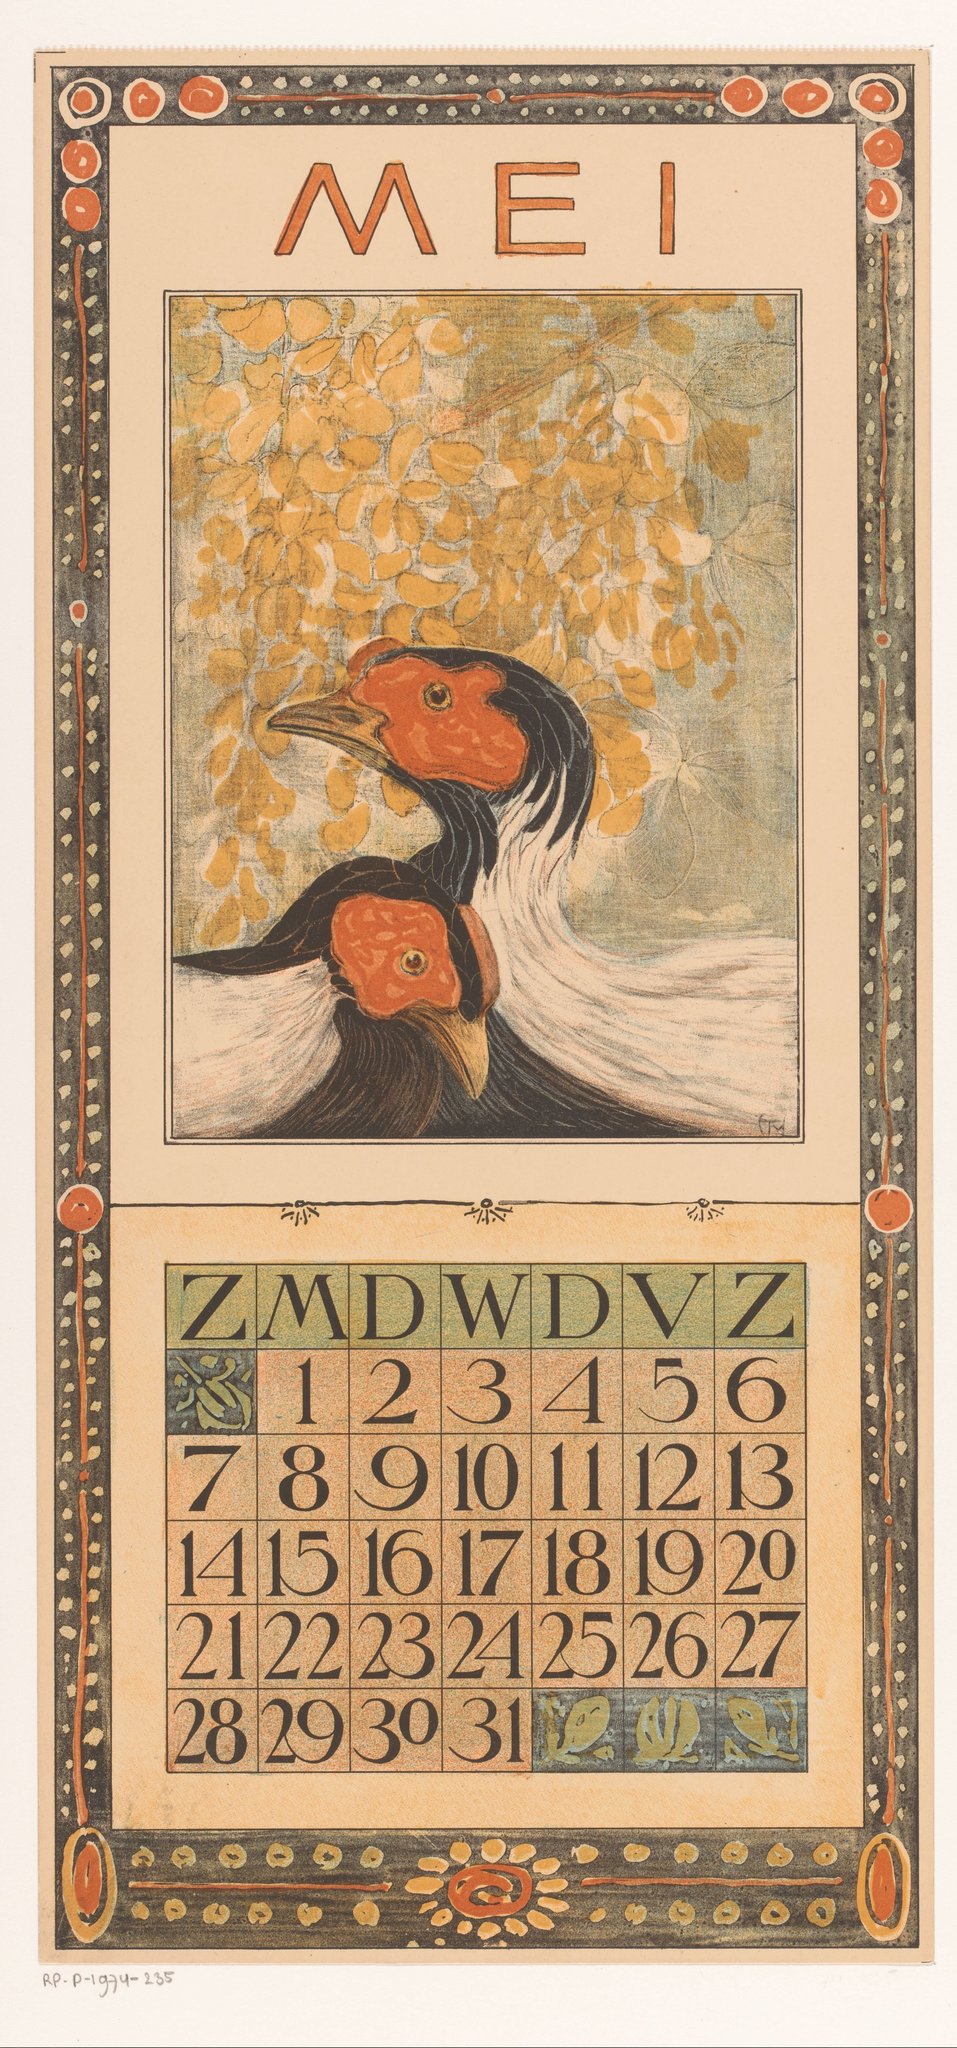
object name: calendar leaf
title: Kalender 1905 12 lithografien door Th. v. Hoytema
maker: theo van hoytema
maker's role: draughtsman, painter, print maker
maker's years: 1863-1917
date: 1904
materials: paper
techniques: lithograph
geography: amsterdam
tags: walker and runner birds: pheasant, may ~ other concepts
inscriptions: collector's mark: Lugt 2228